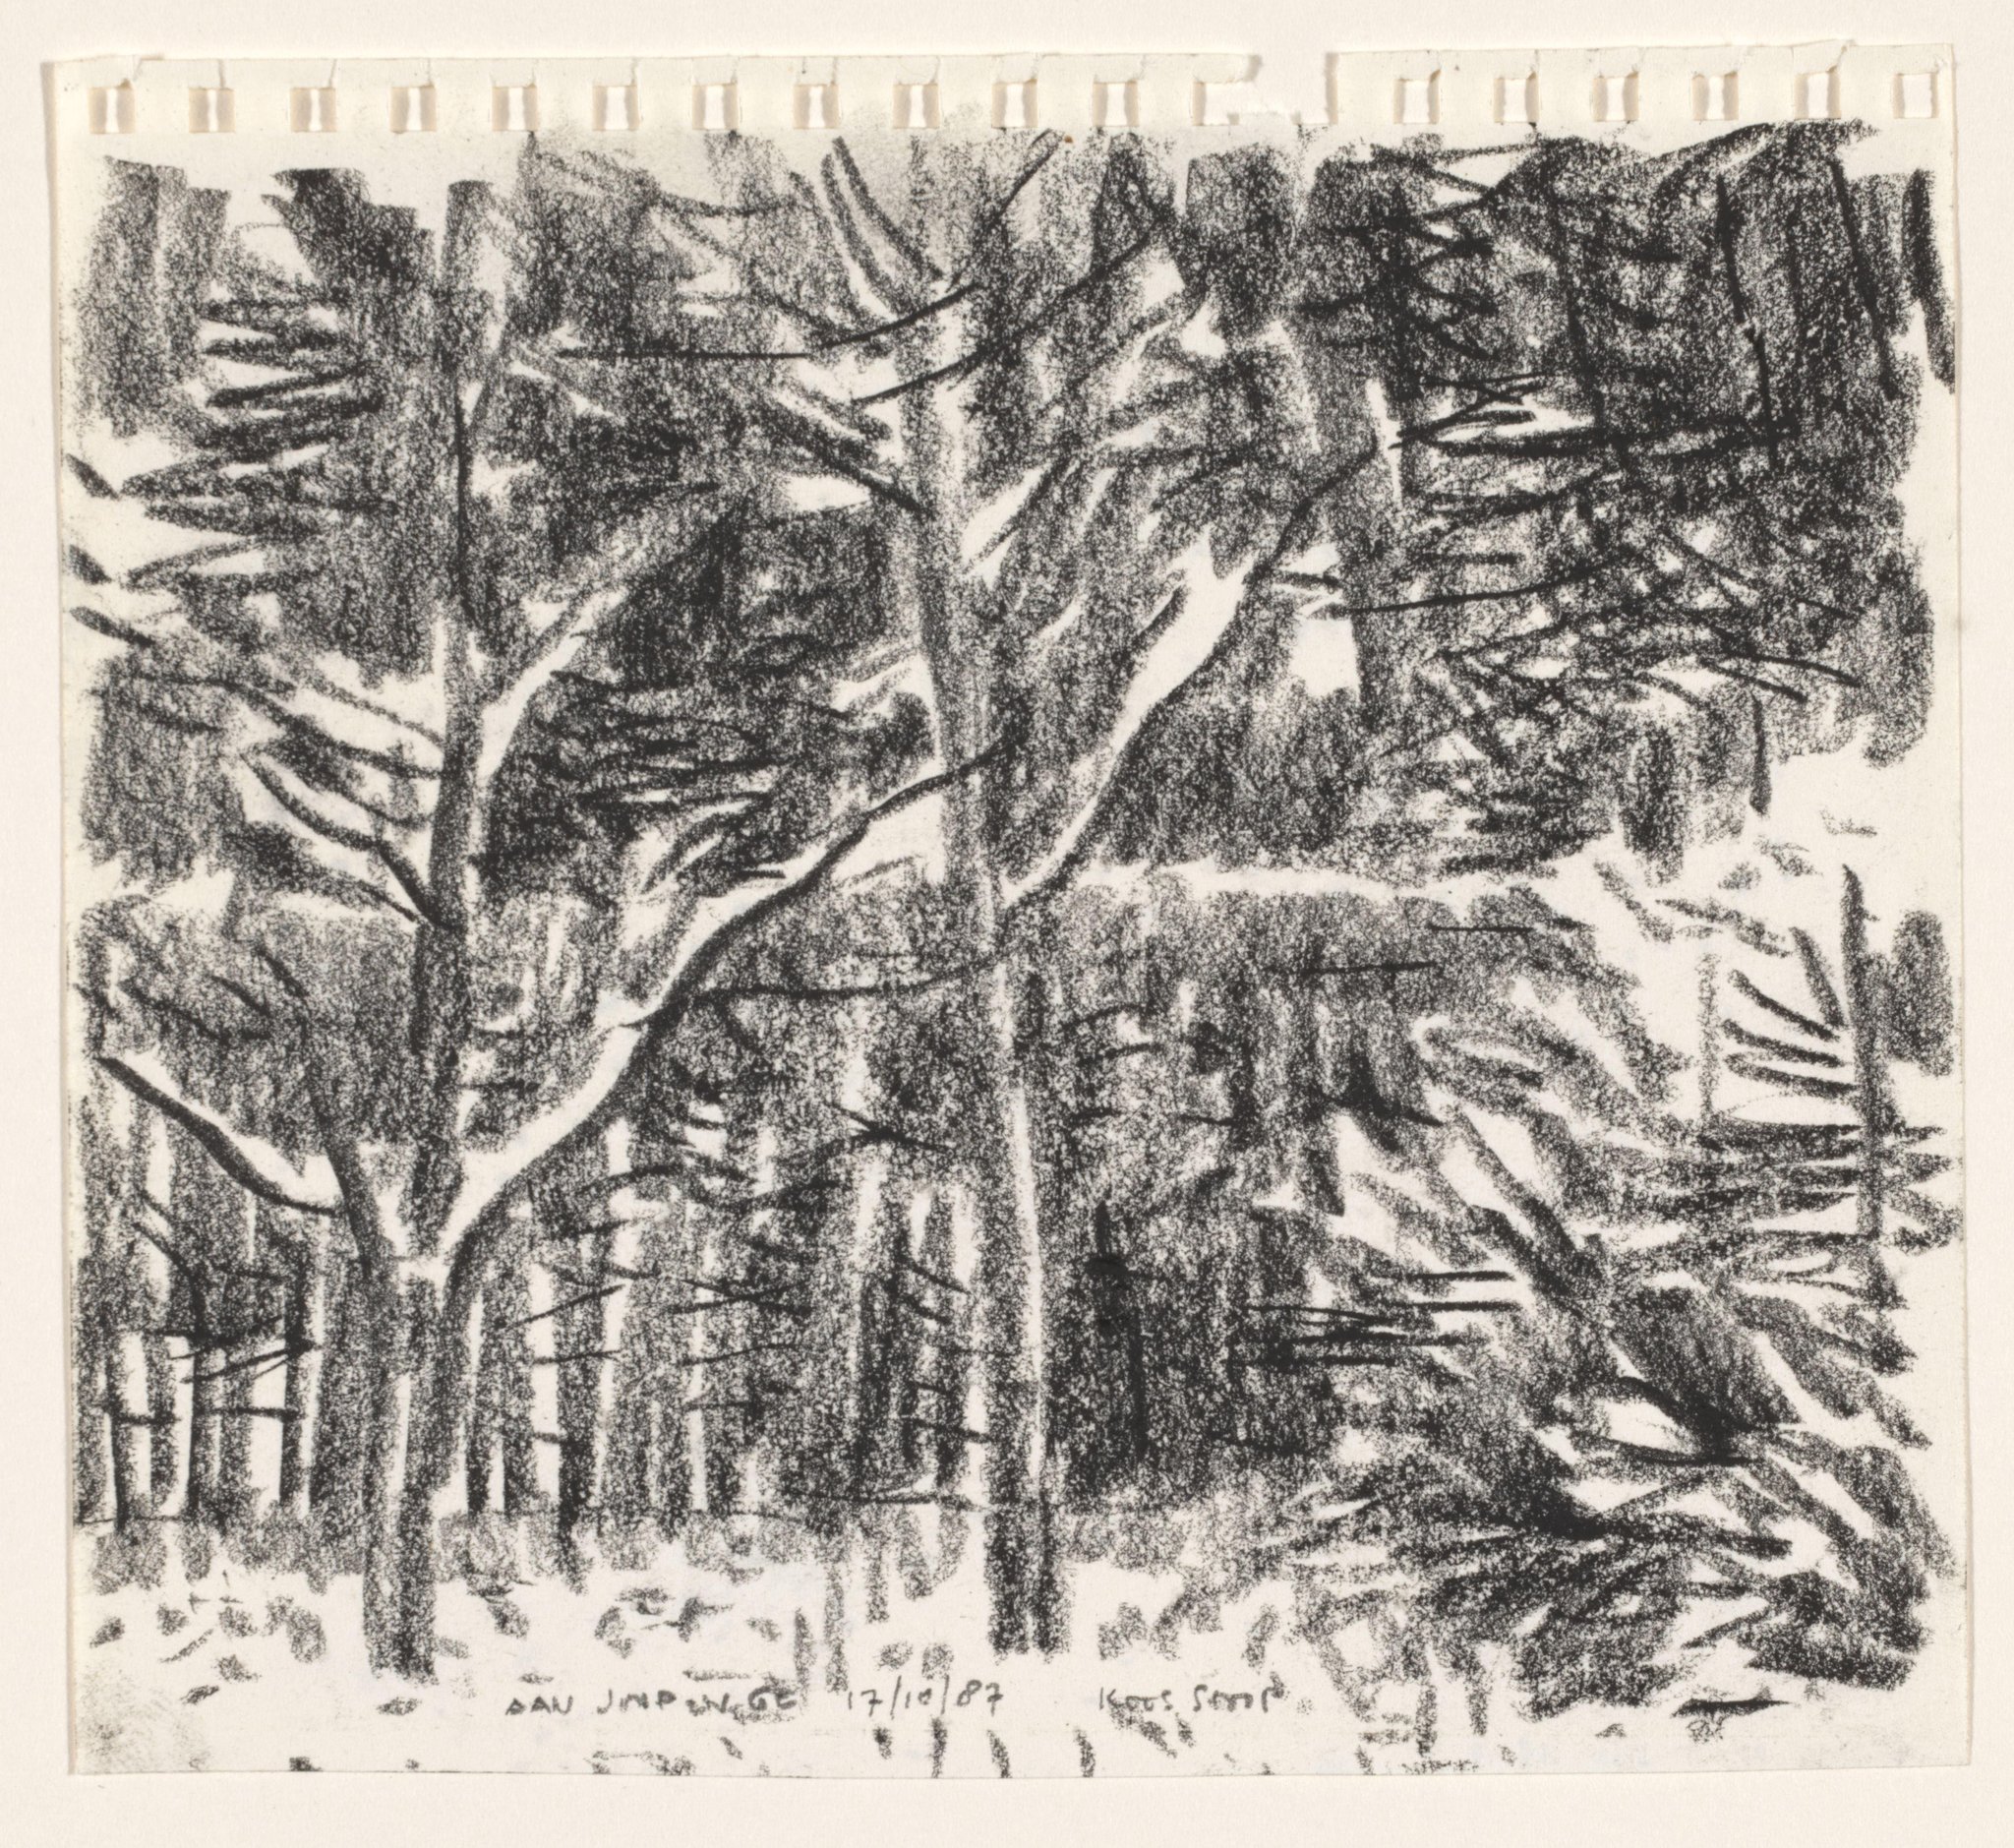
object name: drawing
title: Struikgewas en geboomte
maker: kees stoop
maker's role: draughtsman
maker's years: 1929-2019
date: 1939-2009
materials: charcoal, paper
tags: trees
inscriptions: inscription